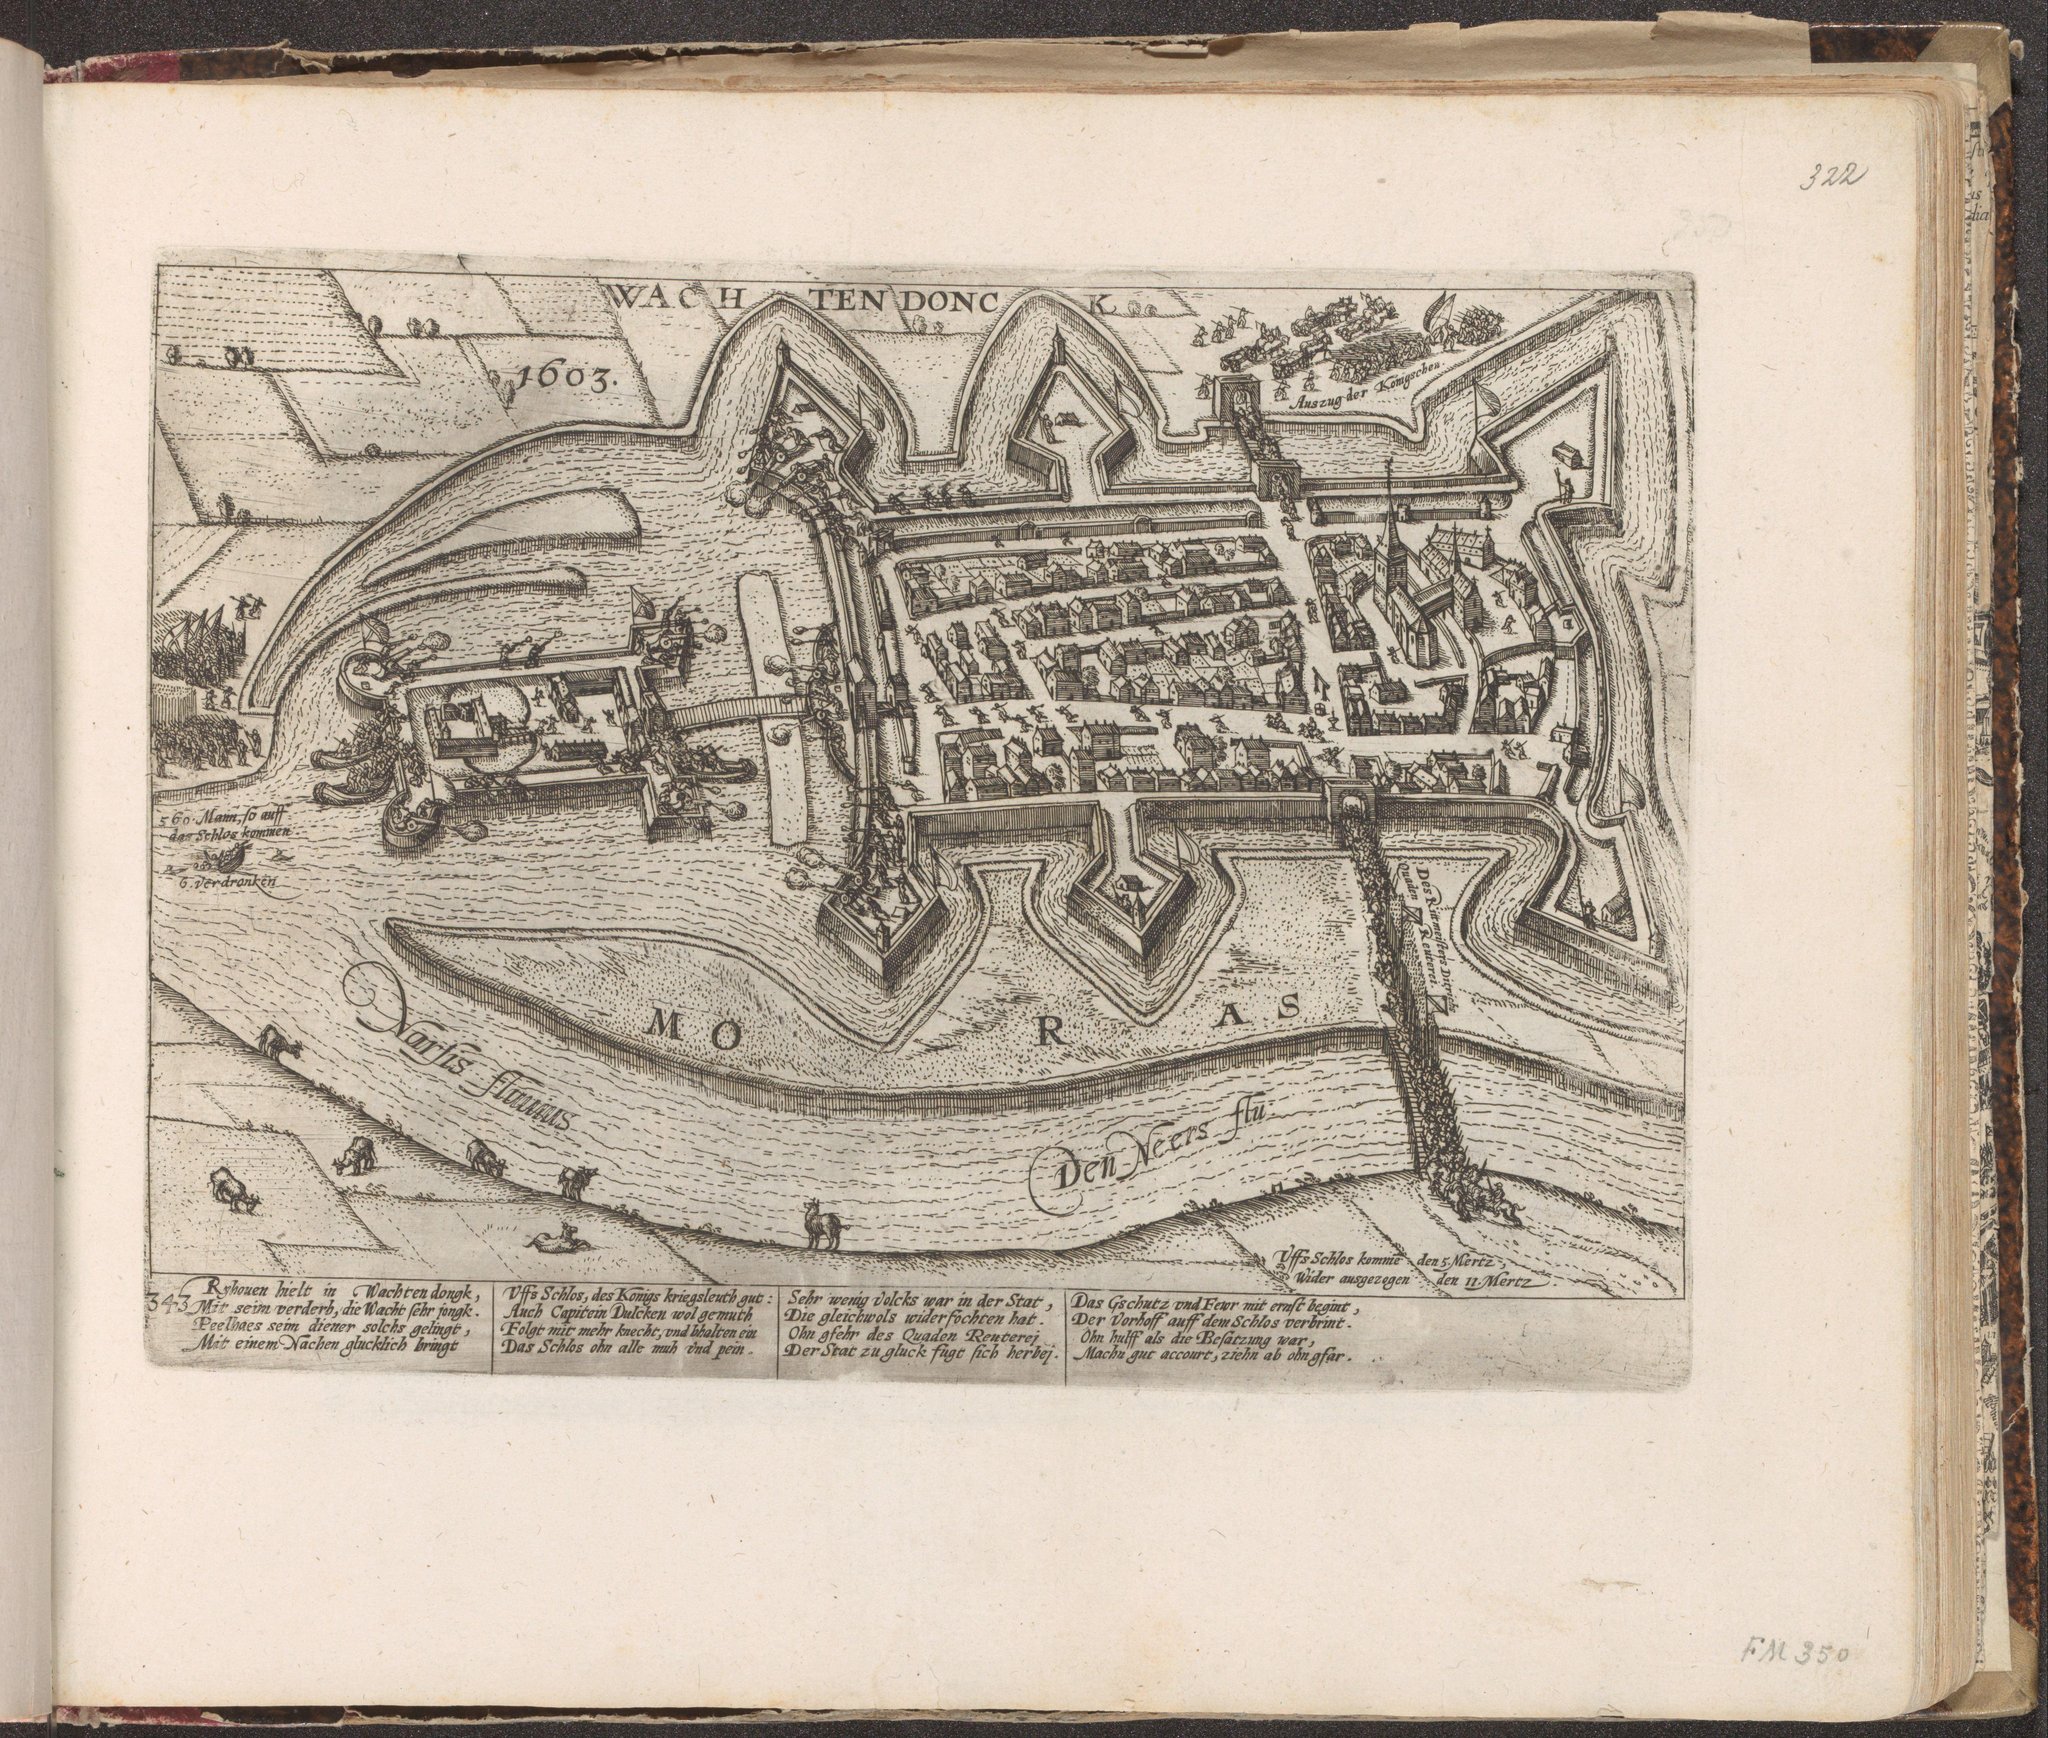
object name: print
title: Wachtendonk bezet door de Spanjaarden, 1603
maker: frans hogenberg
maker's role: print maker, publisher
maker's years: 1538-1590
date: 1603-1605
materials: paper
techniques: engraving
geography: cologne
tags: siege, position war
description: Het kasteel van Wachtendonk bij list ingenomen door de Spanjaarden en zes dagen lang bezet gehouden, 5-11 maart 1603. Gezicht op de stad en de beschietingen met het kasteel, links. Rechtsboven de aftocht van de Spaanse soldaten. Met onderschrift van 16 regels in het Duits. Linksonder genummerd: 343. De prent maakt deel uit van een album.